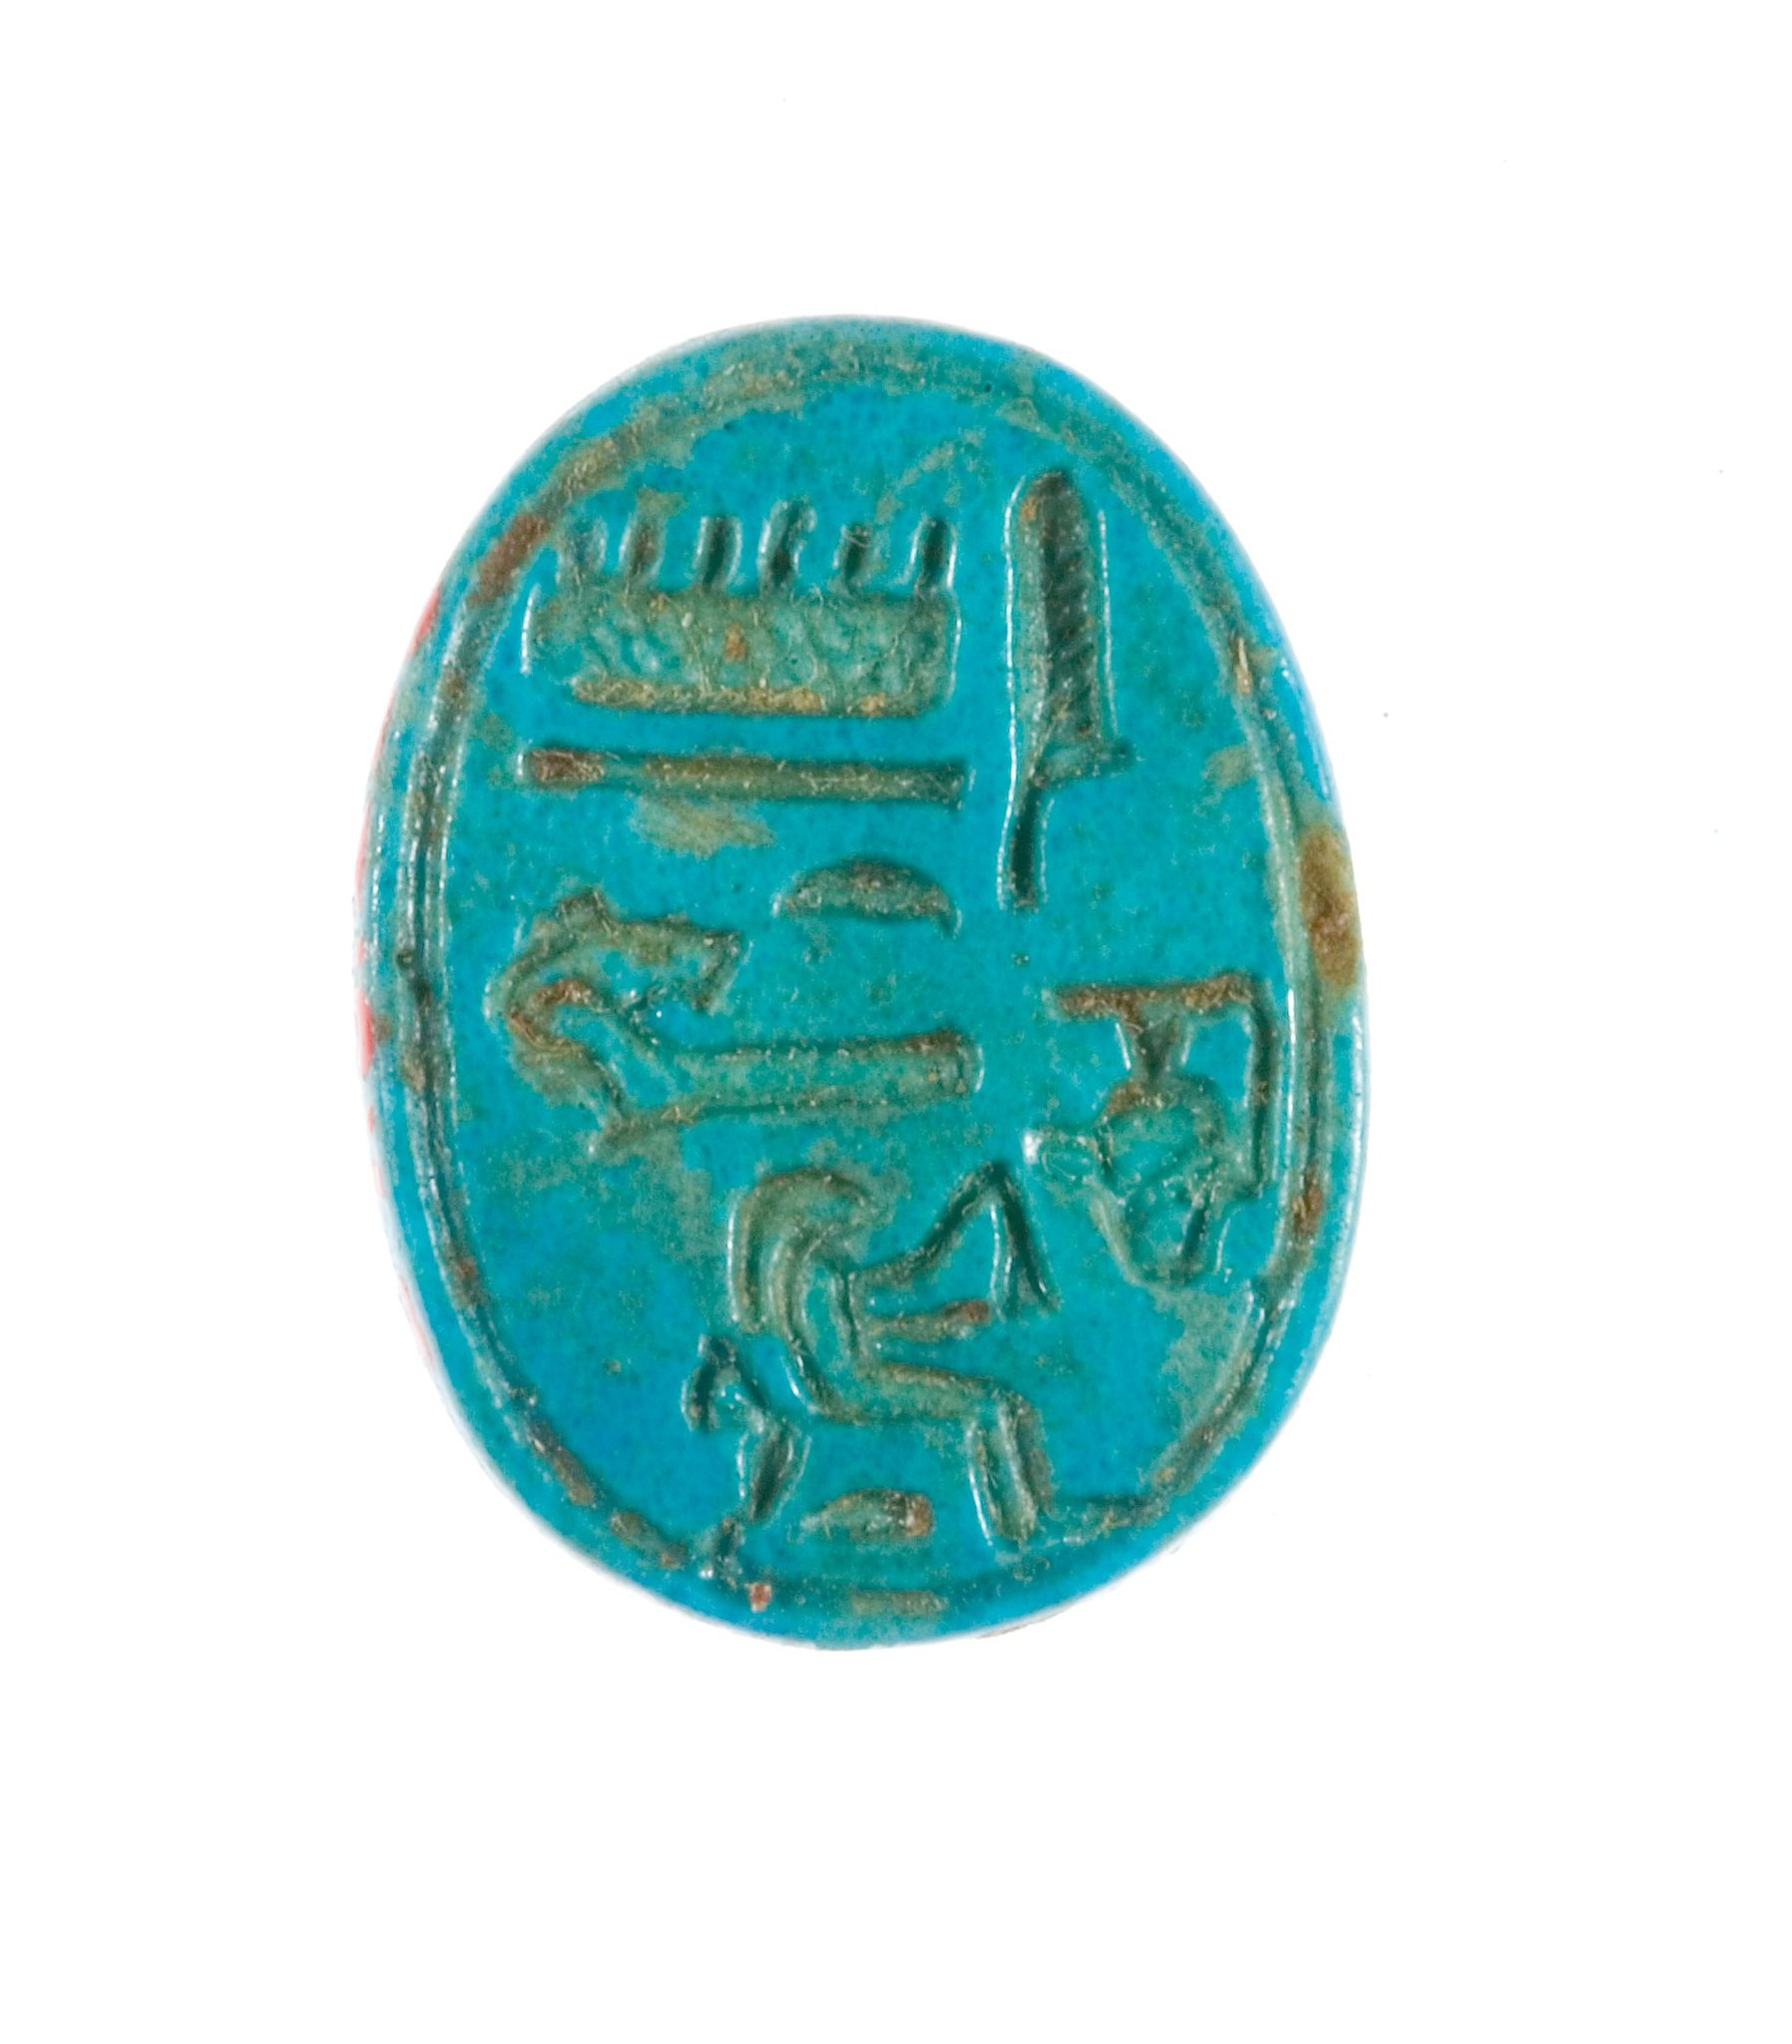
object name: scarab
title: Scarab Inscribed Hatshepsut United with Amun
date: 1479-1458 BCE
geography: egypt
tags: hieroglyphs,scarabs